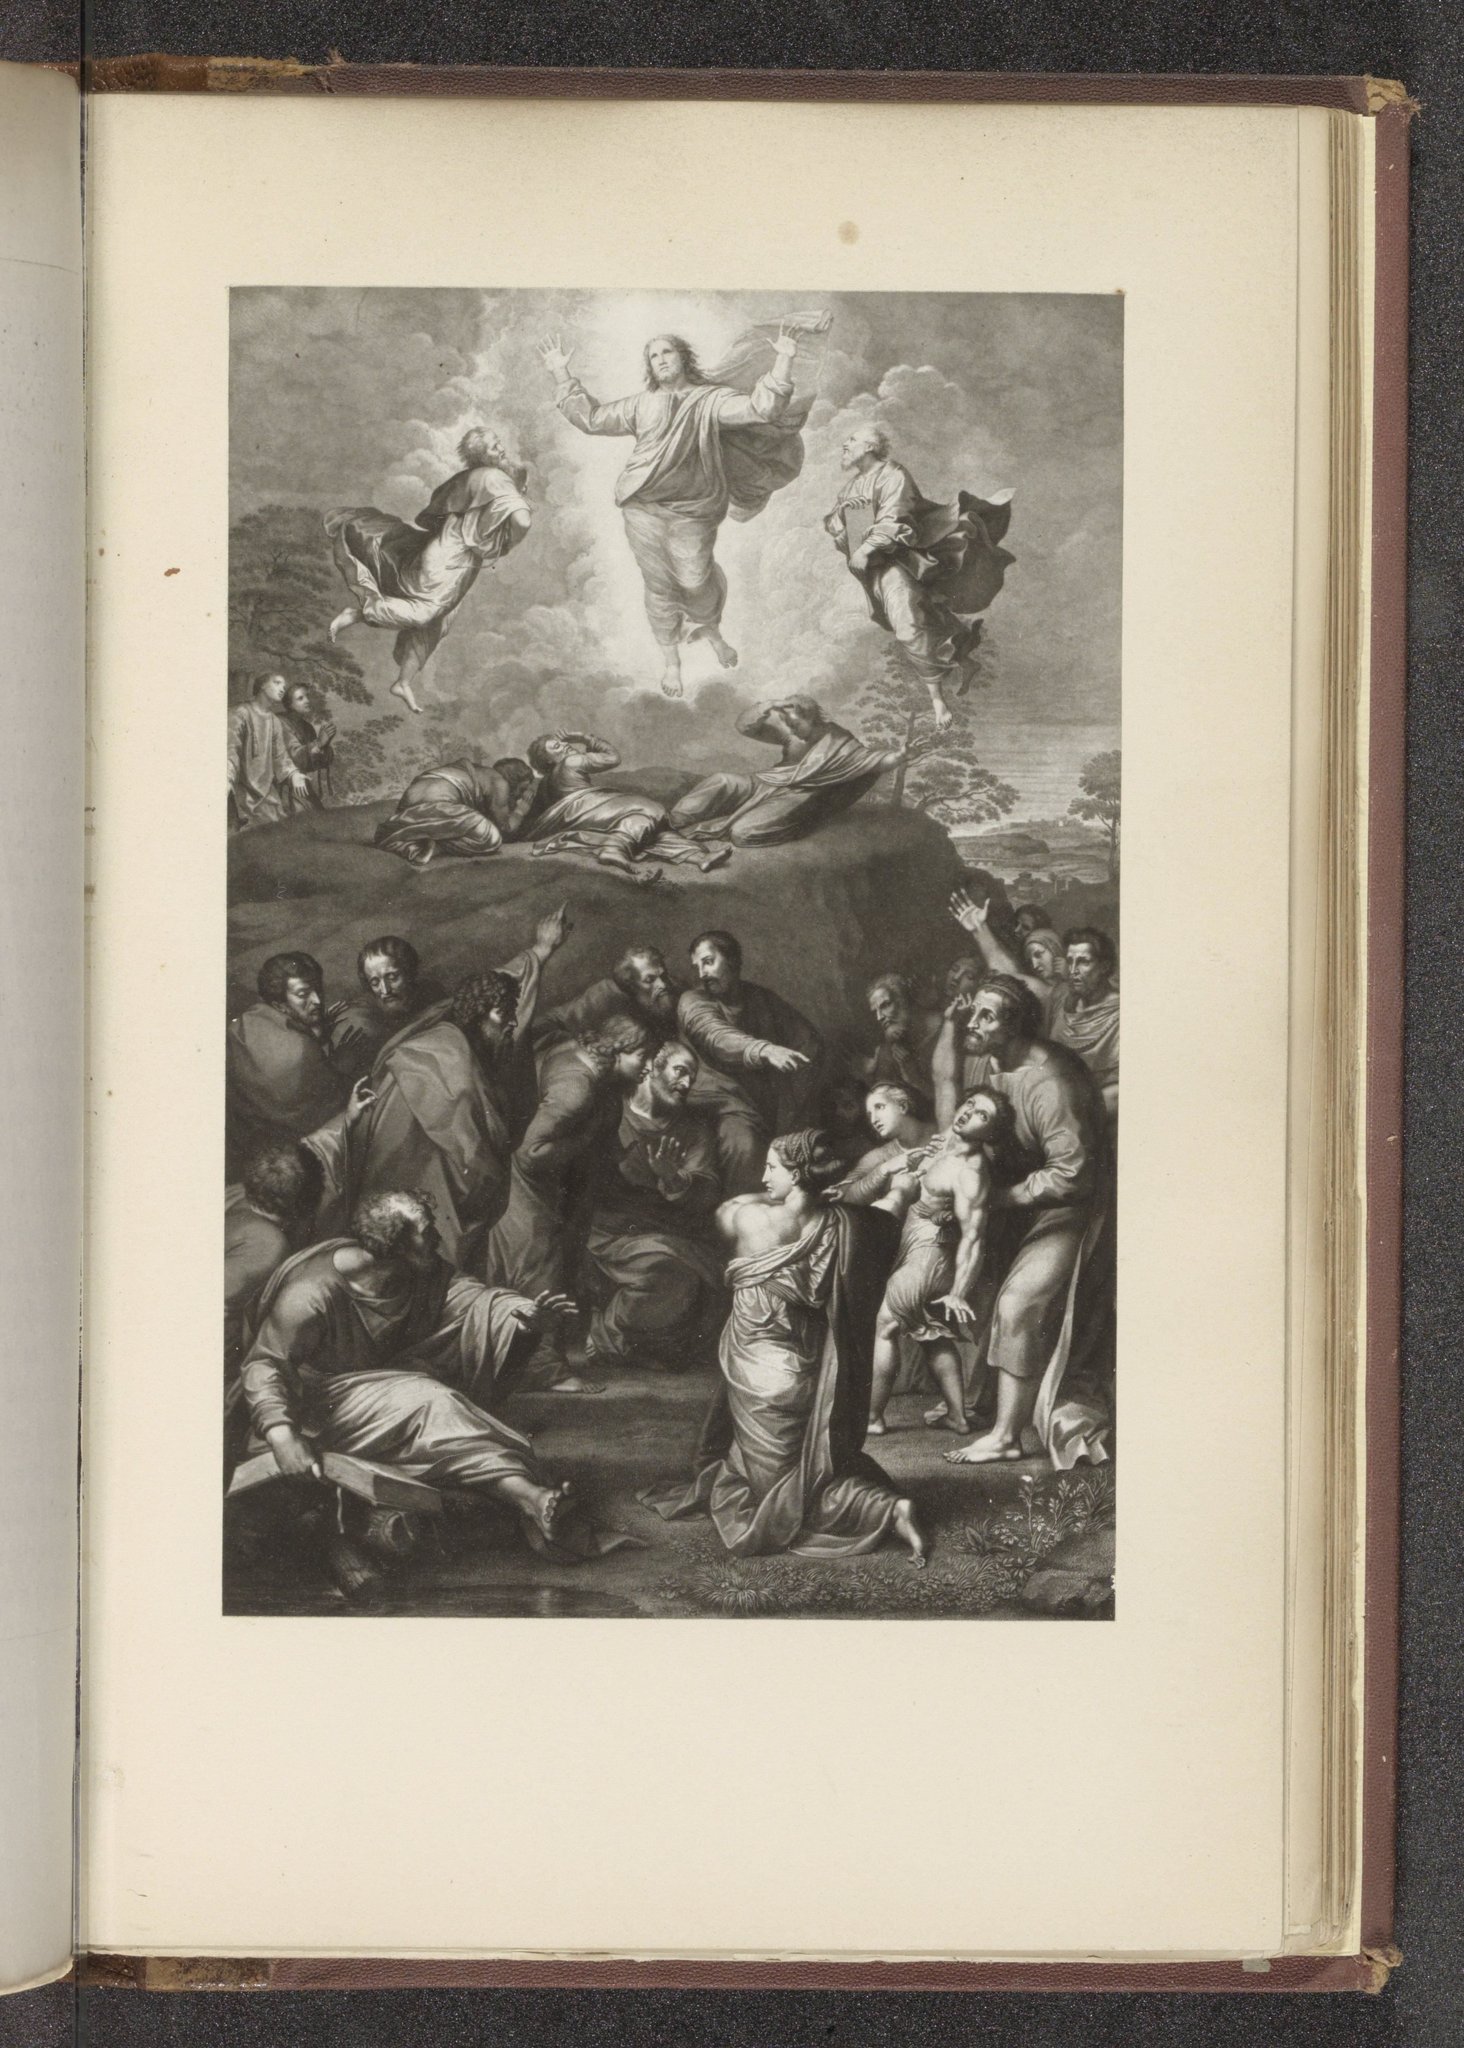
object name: reproduction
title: Fotoreproductie van een prent naar het schilderij De transfiguratie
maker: Anonymous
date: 1872-1882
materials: paper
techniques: woodburytype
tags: the transfiguration: moses and elijah appear on either side of christ on mount tabor (matthew 17:1-13; mark 9:2-13; luke 9:28-36)